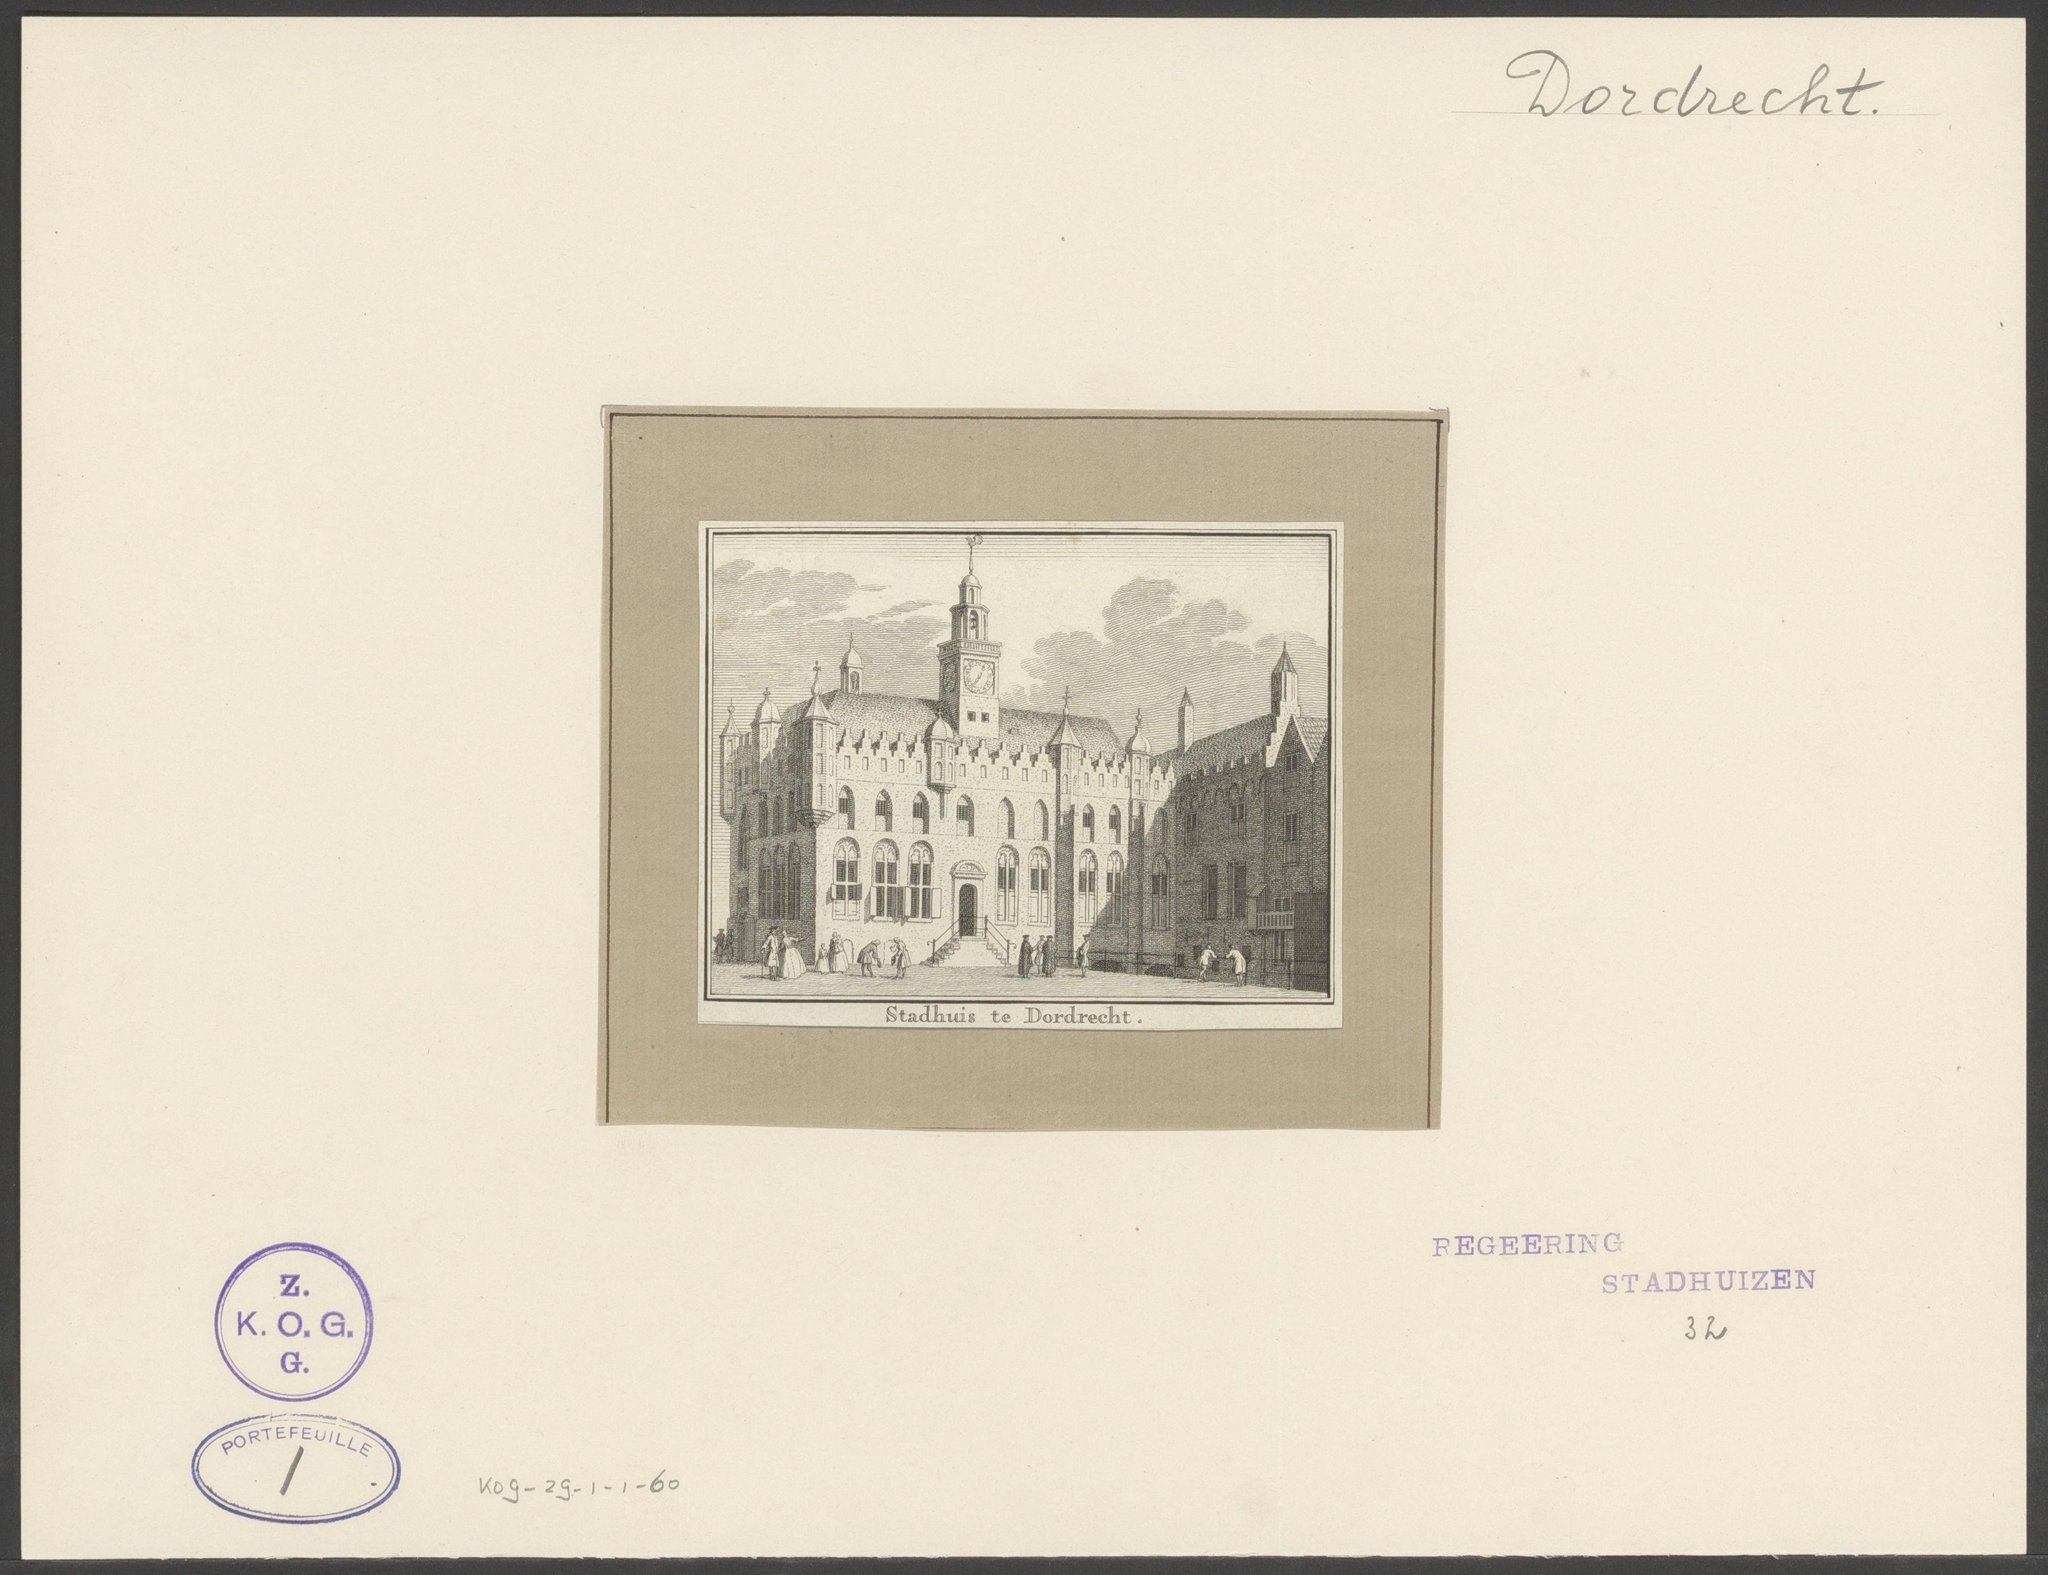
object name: print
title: Stadhuis te Dordrecht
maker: jan caspar philips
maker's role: draughtsman, print maker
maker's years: 1700-1775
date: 1742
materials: paper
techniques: etching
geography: netherlands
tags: townhall, dordrecht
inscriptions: collector's mark: Lugt 1641, collector's mark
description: Het Stadhuis te Dordrecht. Helft van een plaat waarop ook de Grote Kerk stond, en de datum en de namen van de vervaardigers. Onderwerpsrubrieken binnen de Atlas Zeden en Gewoonten: Regeering, Stadhuizen (B-D).